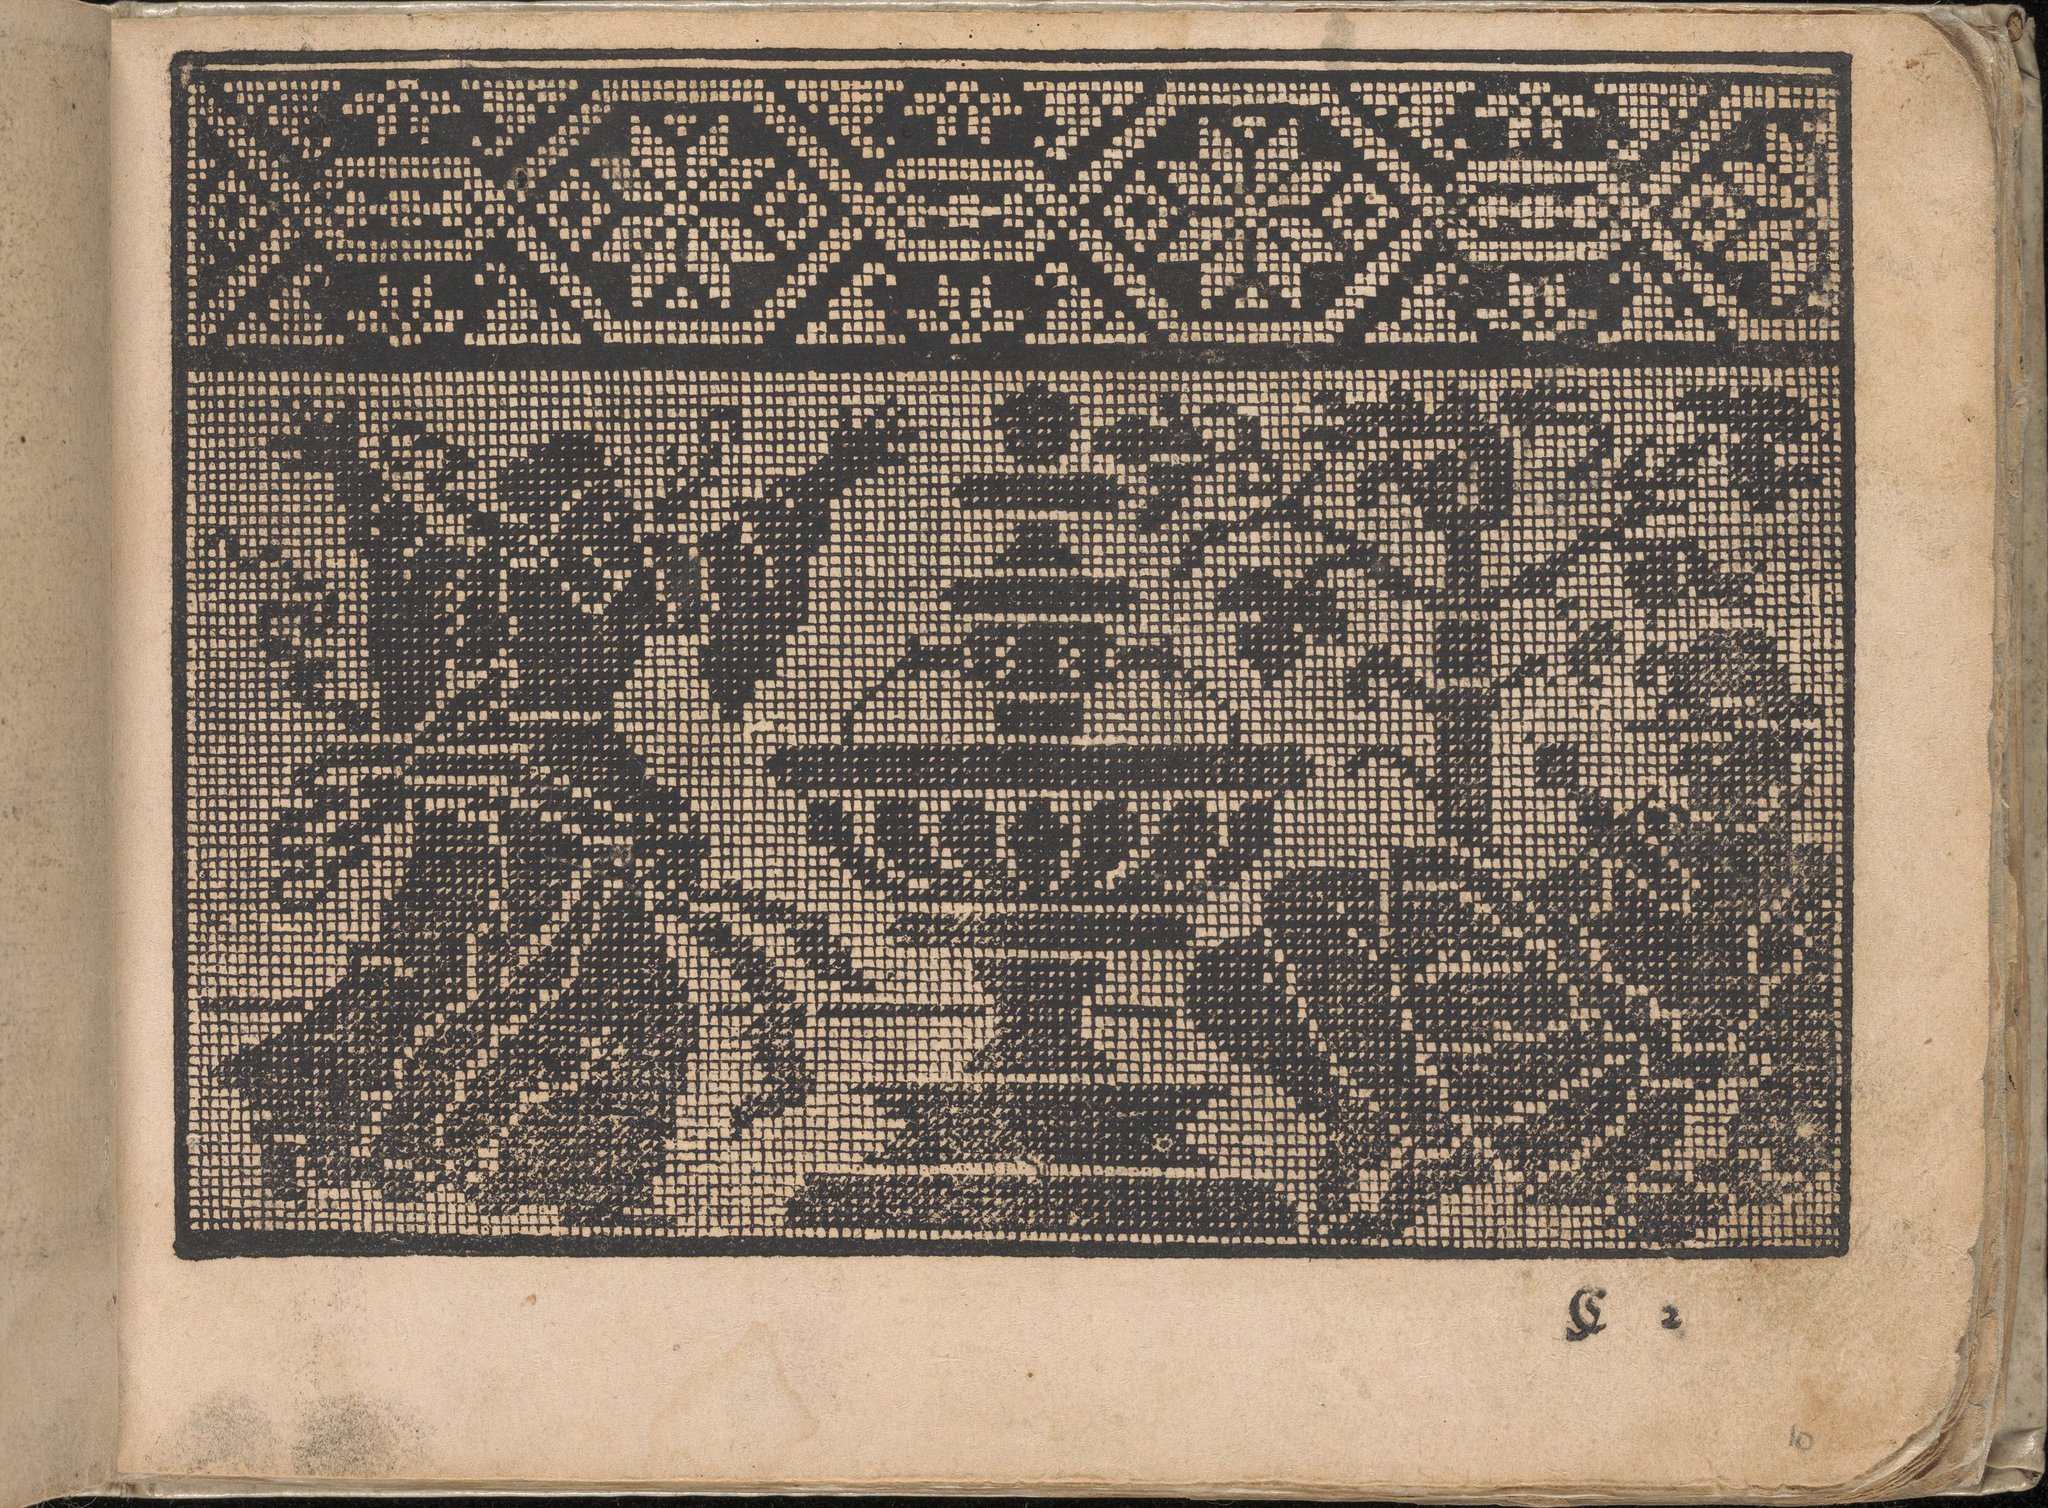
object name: book print ornament architecture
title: Neu künstlich Modelbuch (page 10r)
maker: bernhard jobin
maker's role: publisher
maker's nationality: swiss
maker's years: 1535-1597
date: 1598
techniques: woodcut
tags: human figures,fountains